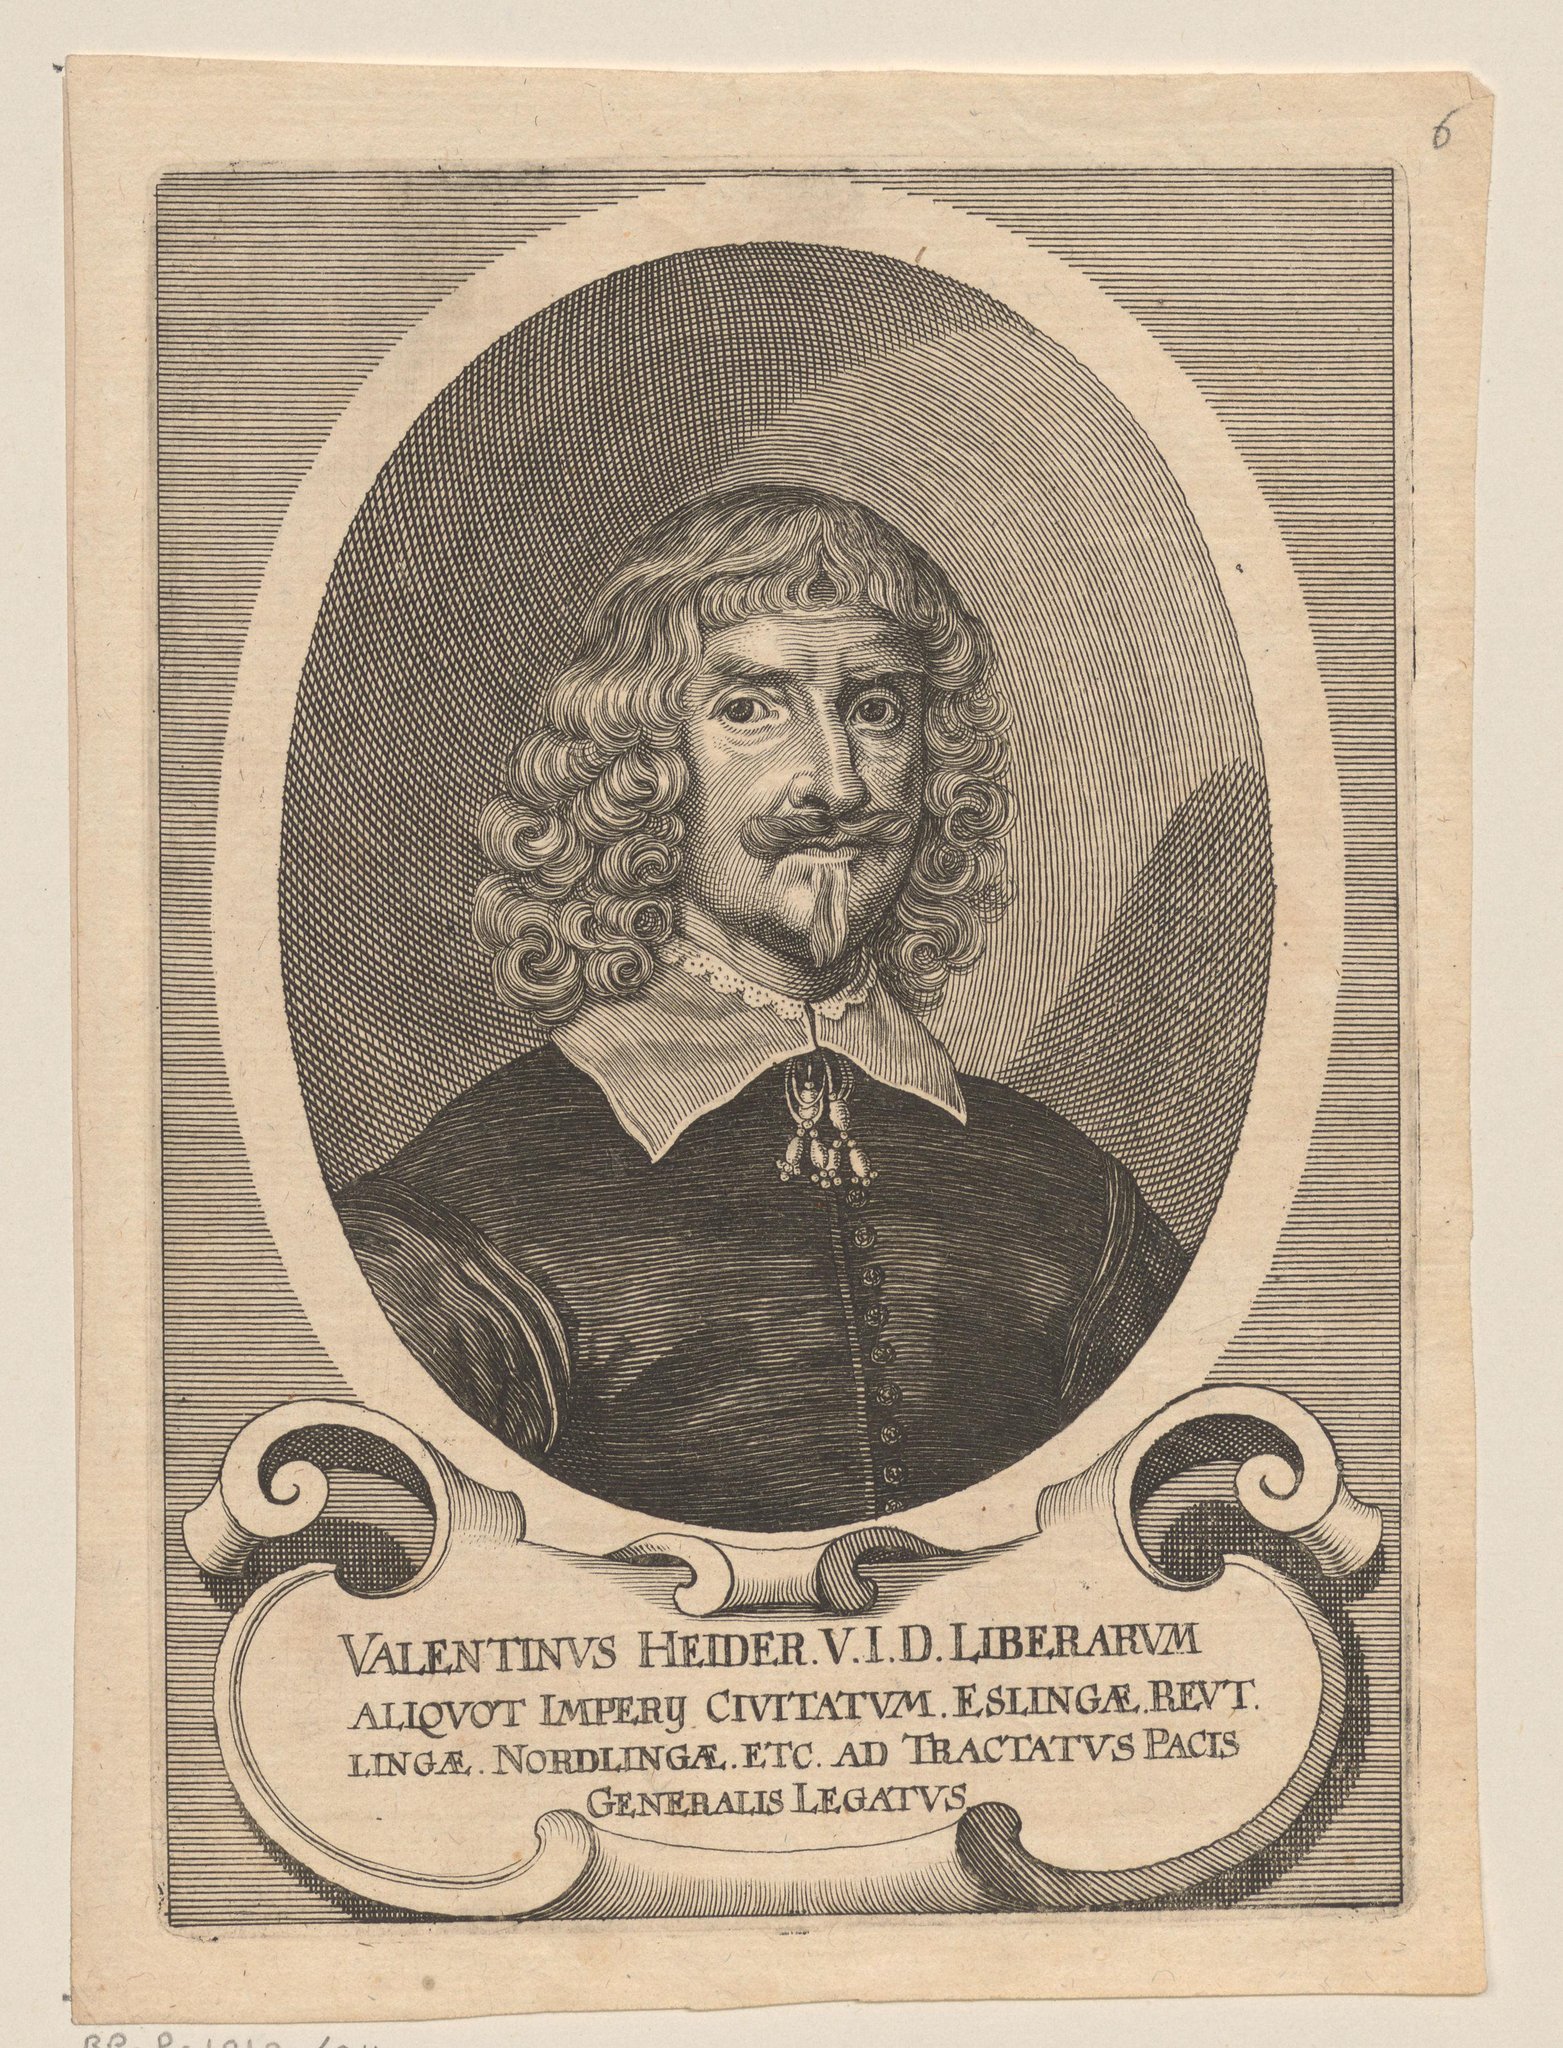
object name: print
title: Portret van Valentin Heider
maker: Anonymous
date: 1650-1699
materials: paper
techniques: engraving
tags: official; civil servant; functionary (in general), historical persons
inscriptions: collector's mark: Lugt 2233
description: Prent gebruikt in: Theatrum Europaeum. Frankfurt am Main: erven Matthäus Merian, 1652, dl. 6. Ook gebruikt in latere edities van dit werk.